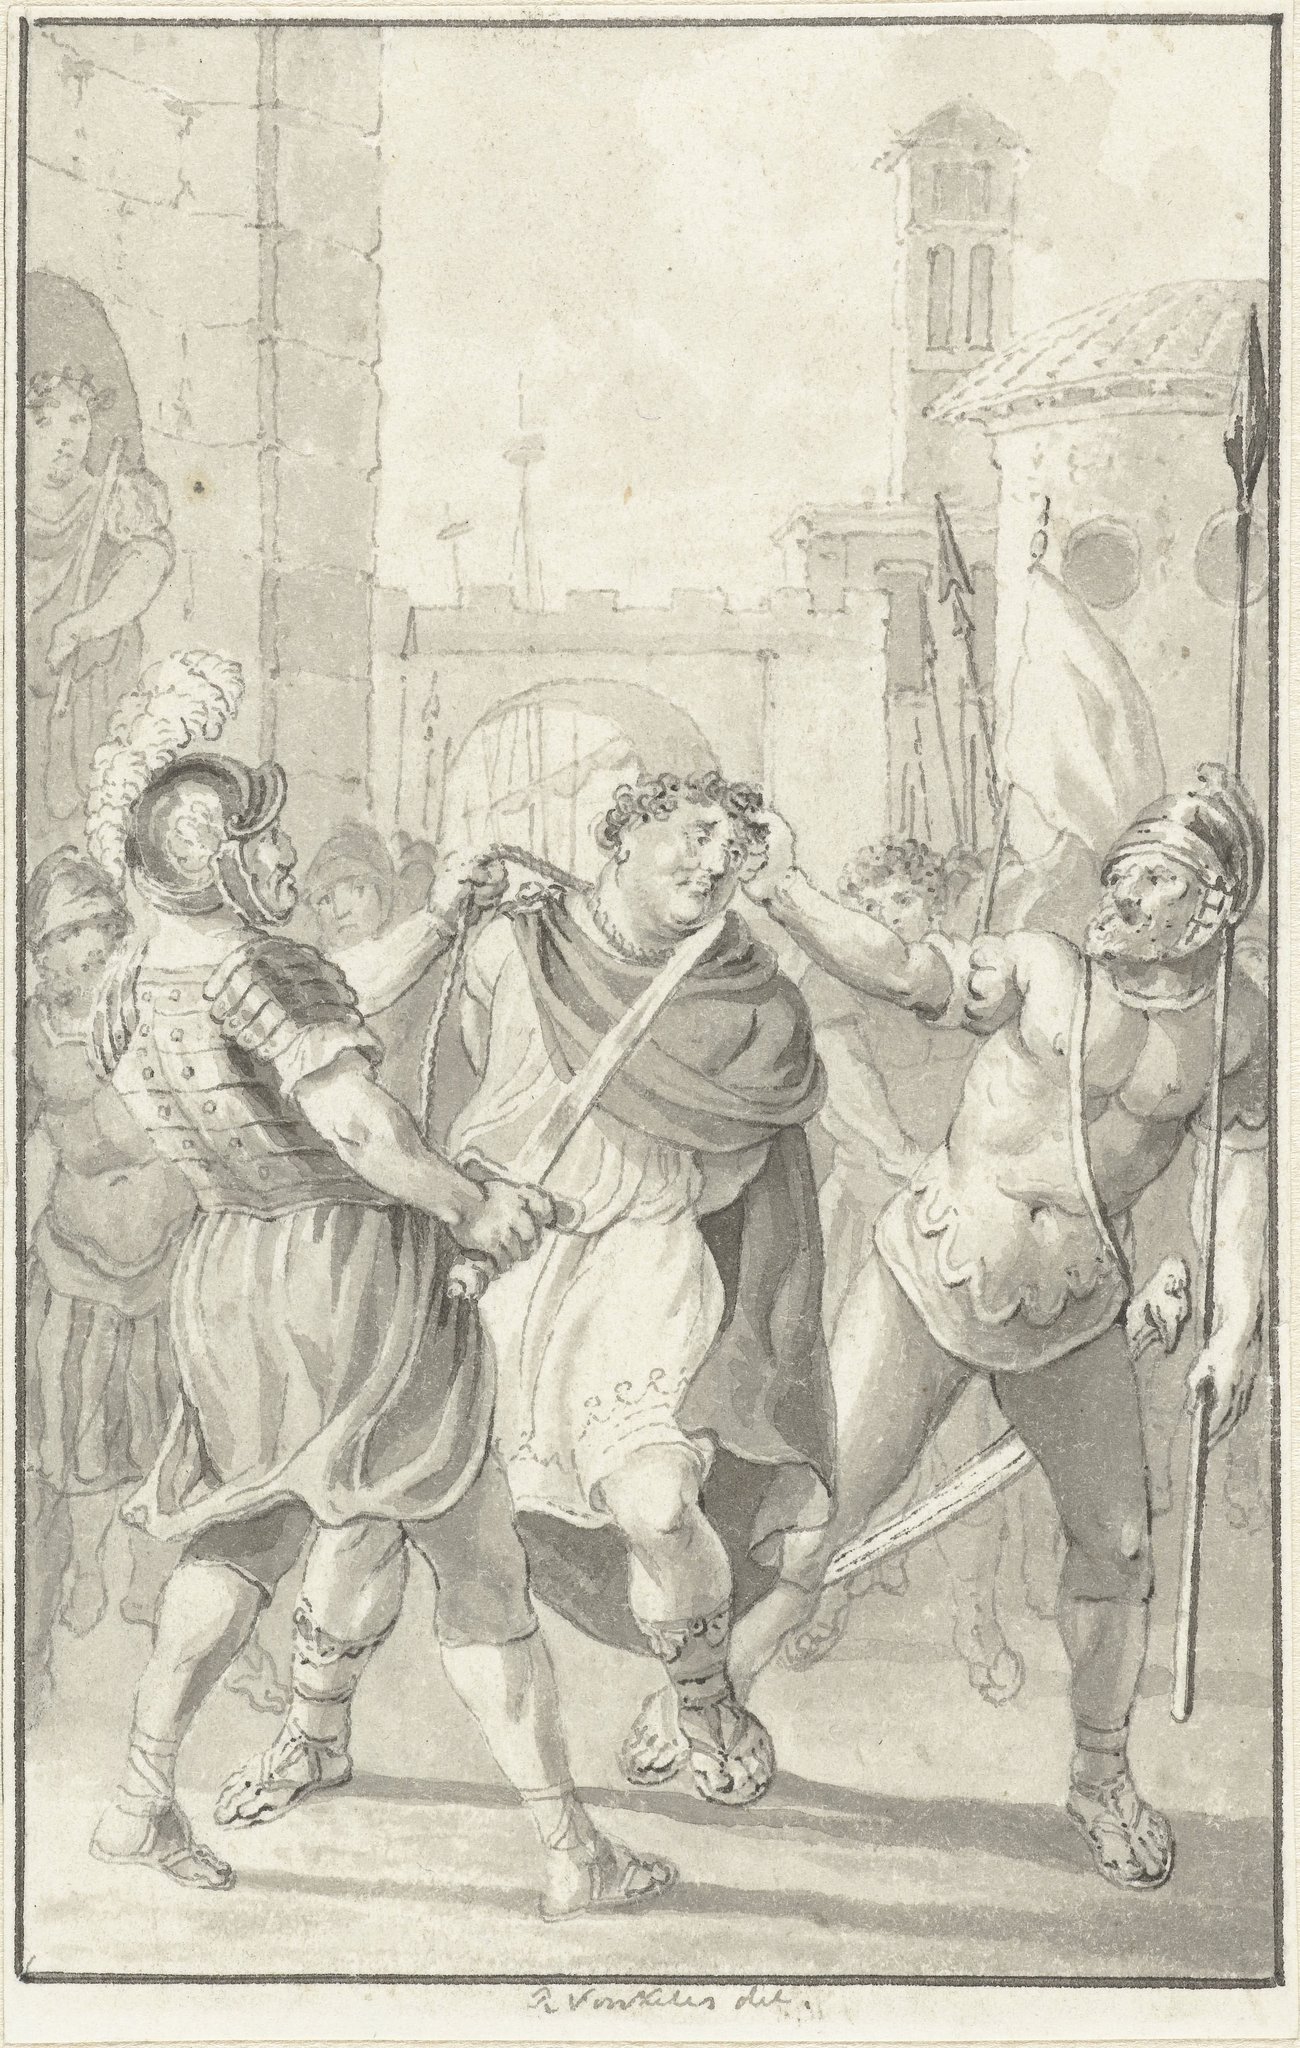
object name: drawing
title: Keizer Vitellius op weg naar zijn terechtstelling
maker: reinier vinkeles (i)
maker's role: draughtsman, print maker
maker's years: 1741-1816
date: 1804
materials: ink, paper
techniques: brush, pen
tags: male persons from classical history (vitellius) - suffering, misfortune of person from classical history, murder, historical events and situations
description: Ontwerp voor gravure door Ludwig Portman in M. Stuart's `Romeinsche Geschiedenissen', 1804, dl. 25 t.o. p. 214.